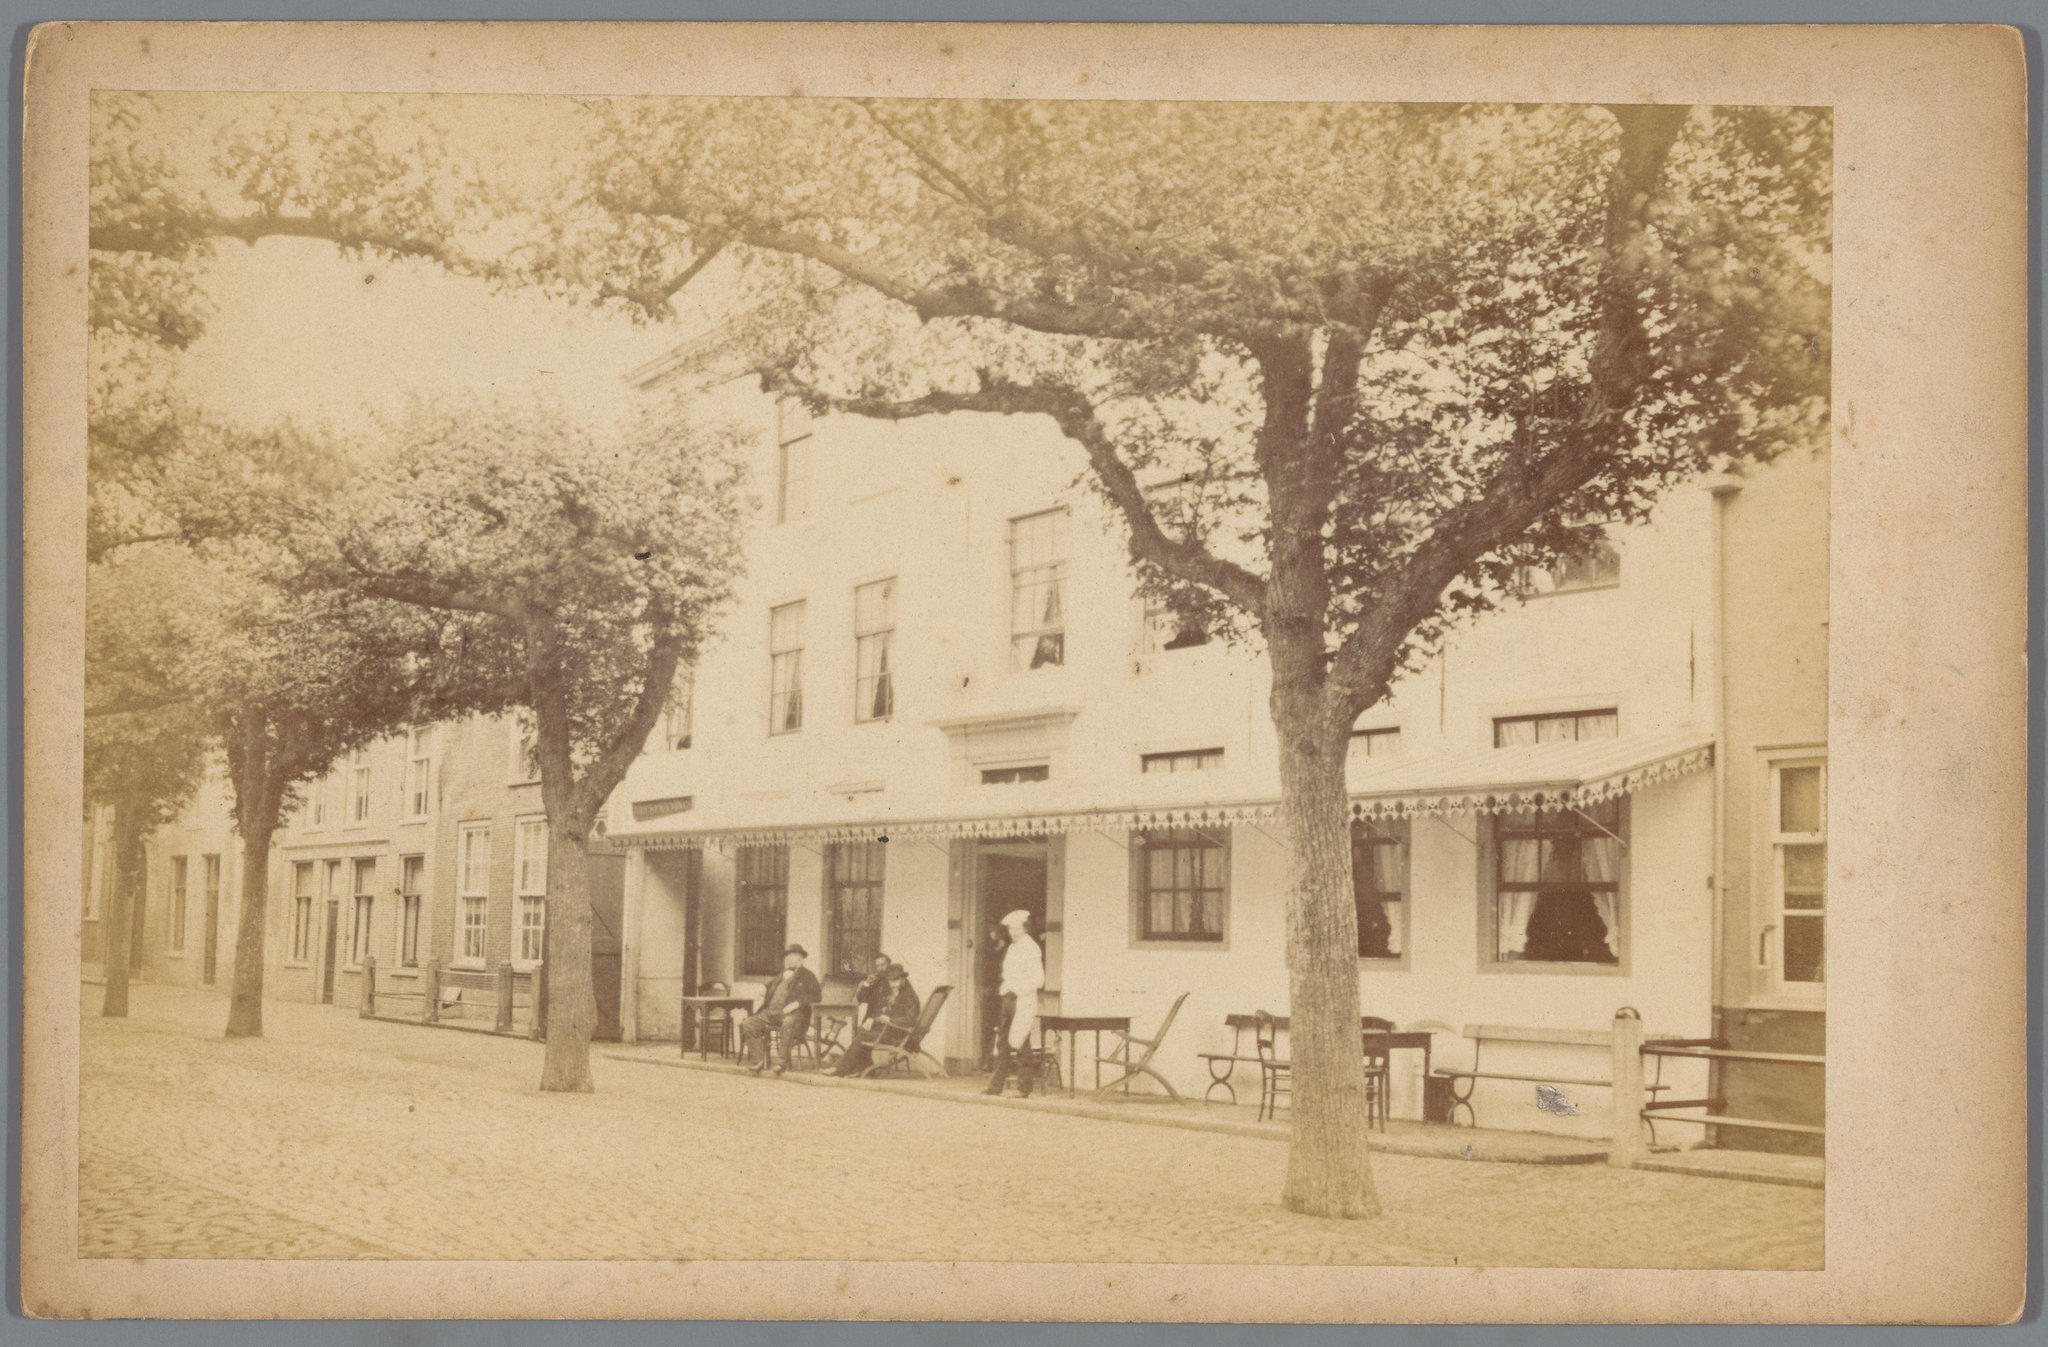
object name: cabinet photograph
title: Gezicht op hotel Hof van Holland in Noordwijk-Binnen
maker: jan goedeljee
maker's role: fotograaf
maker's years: 1824-1905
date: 1865-1885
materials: cardboard, photographic support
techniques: albumen print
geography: leiden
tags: inn, coffee-house, public house, etc.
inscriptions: name: ‘Vosmaer’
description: Gezicht op hotel Hof van Holland in de Voorstraat in Noordwijk-Binnen. Voor het hotel een rij lindebomen.